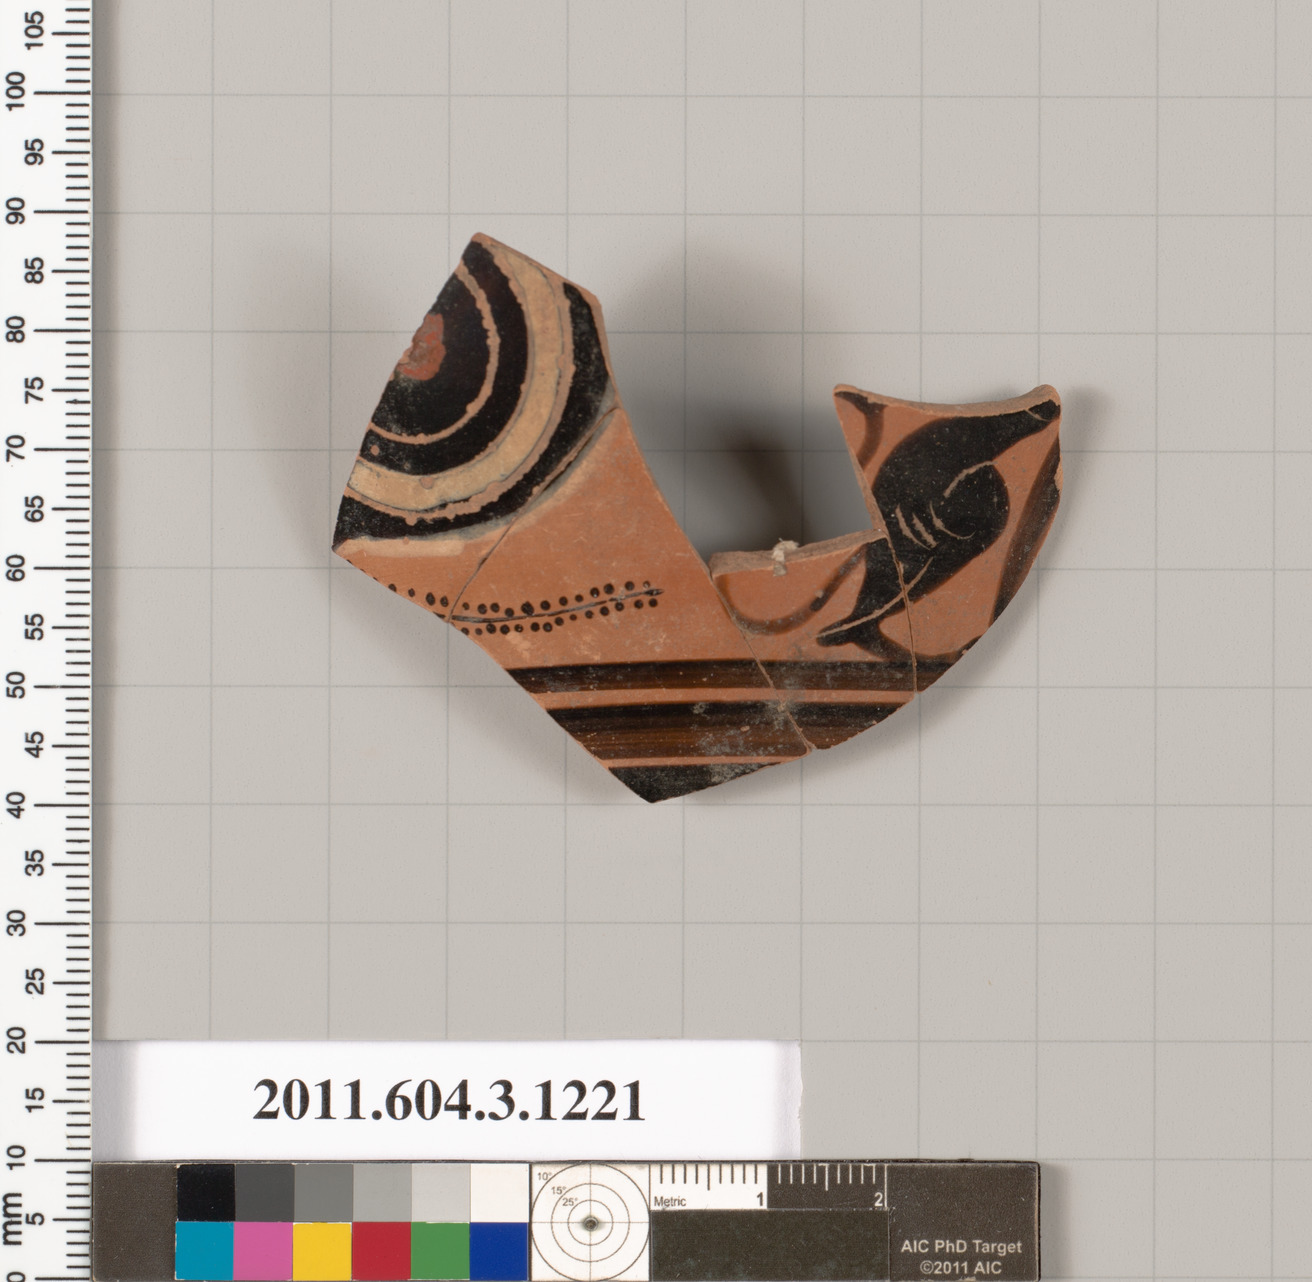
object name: kyathos fragment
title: Terracotta rim fragment of a kyathos (cup-shaped ladle)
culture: greek, attic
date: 534-468 BCE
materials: terracotta